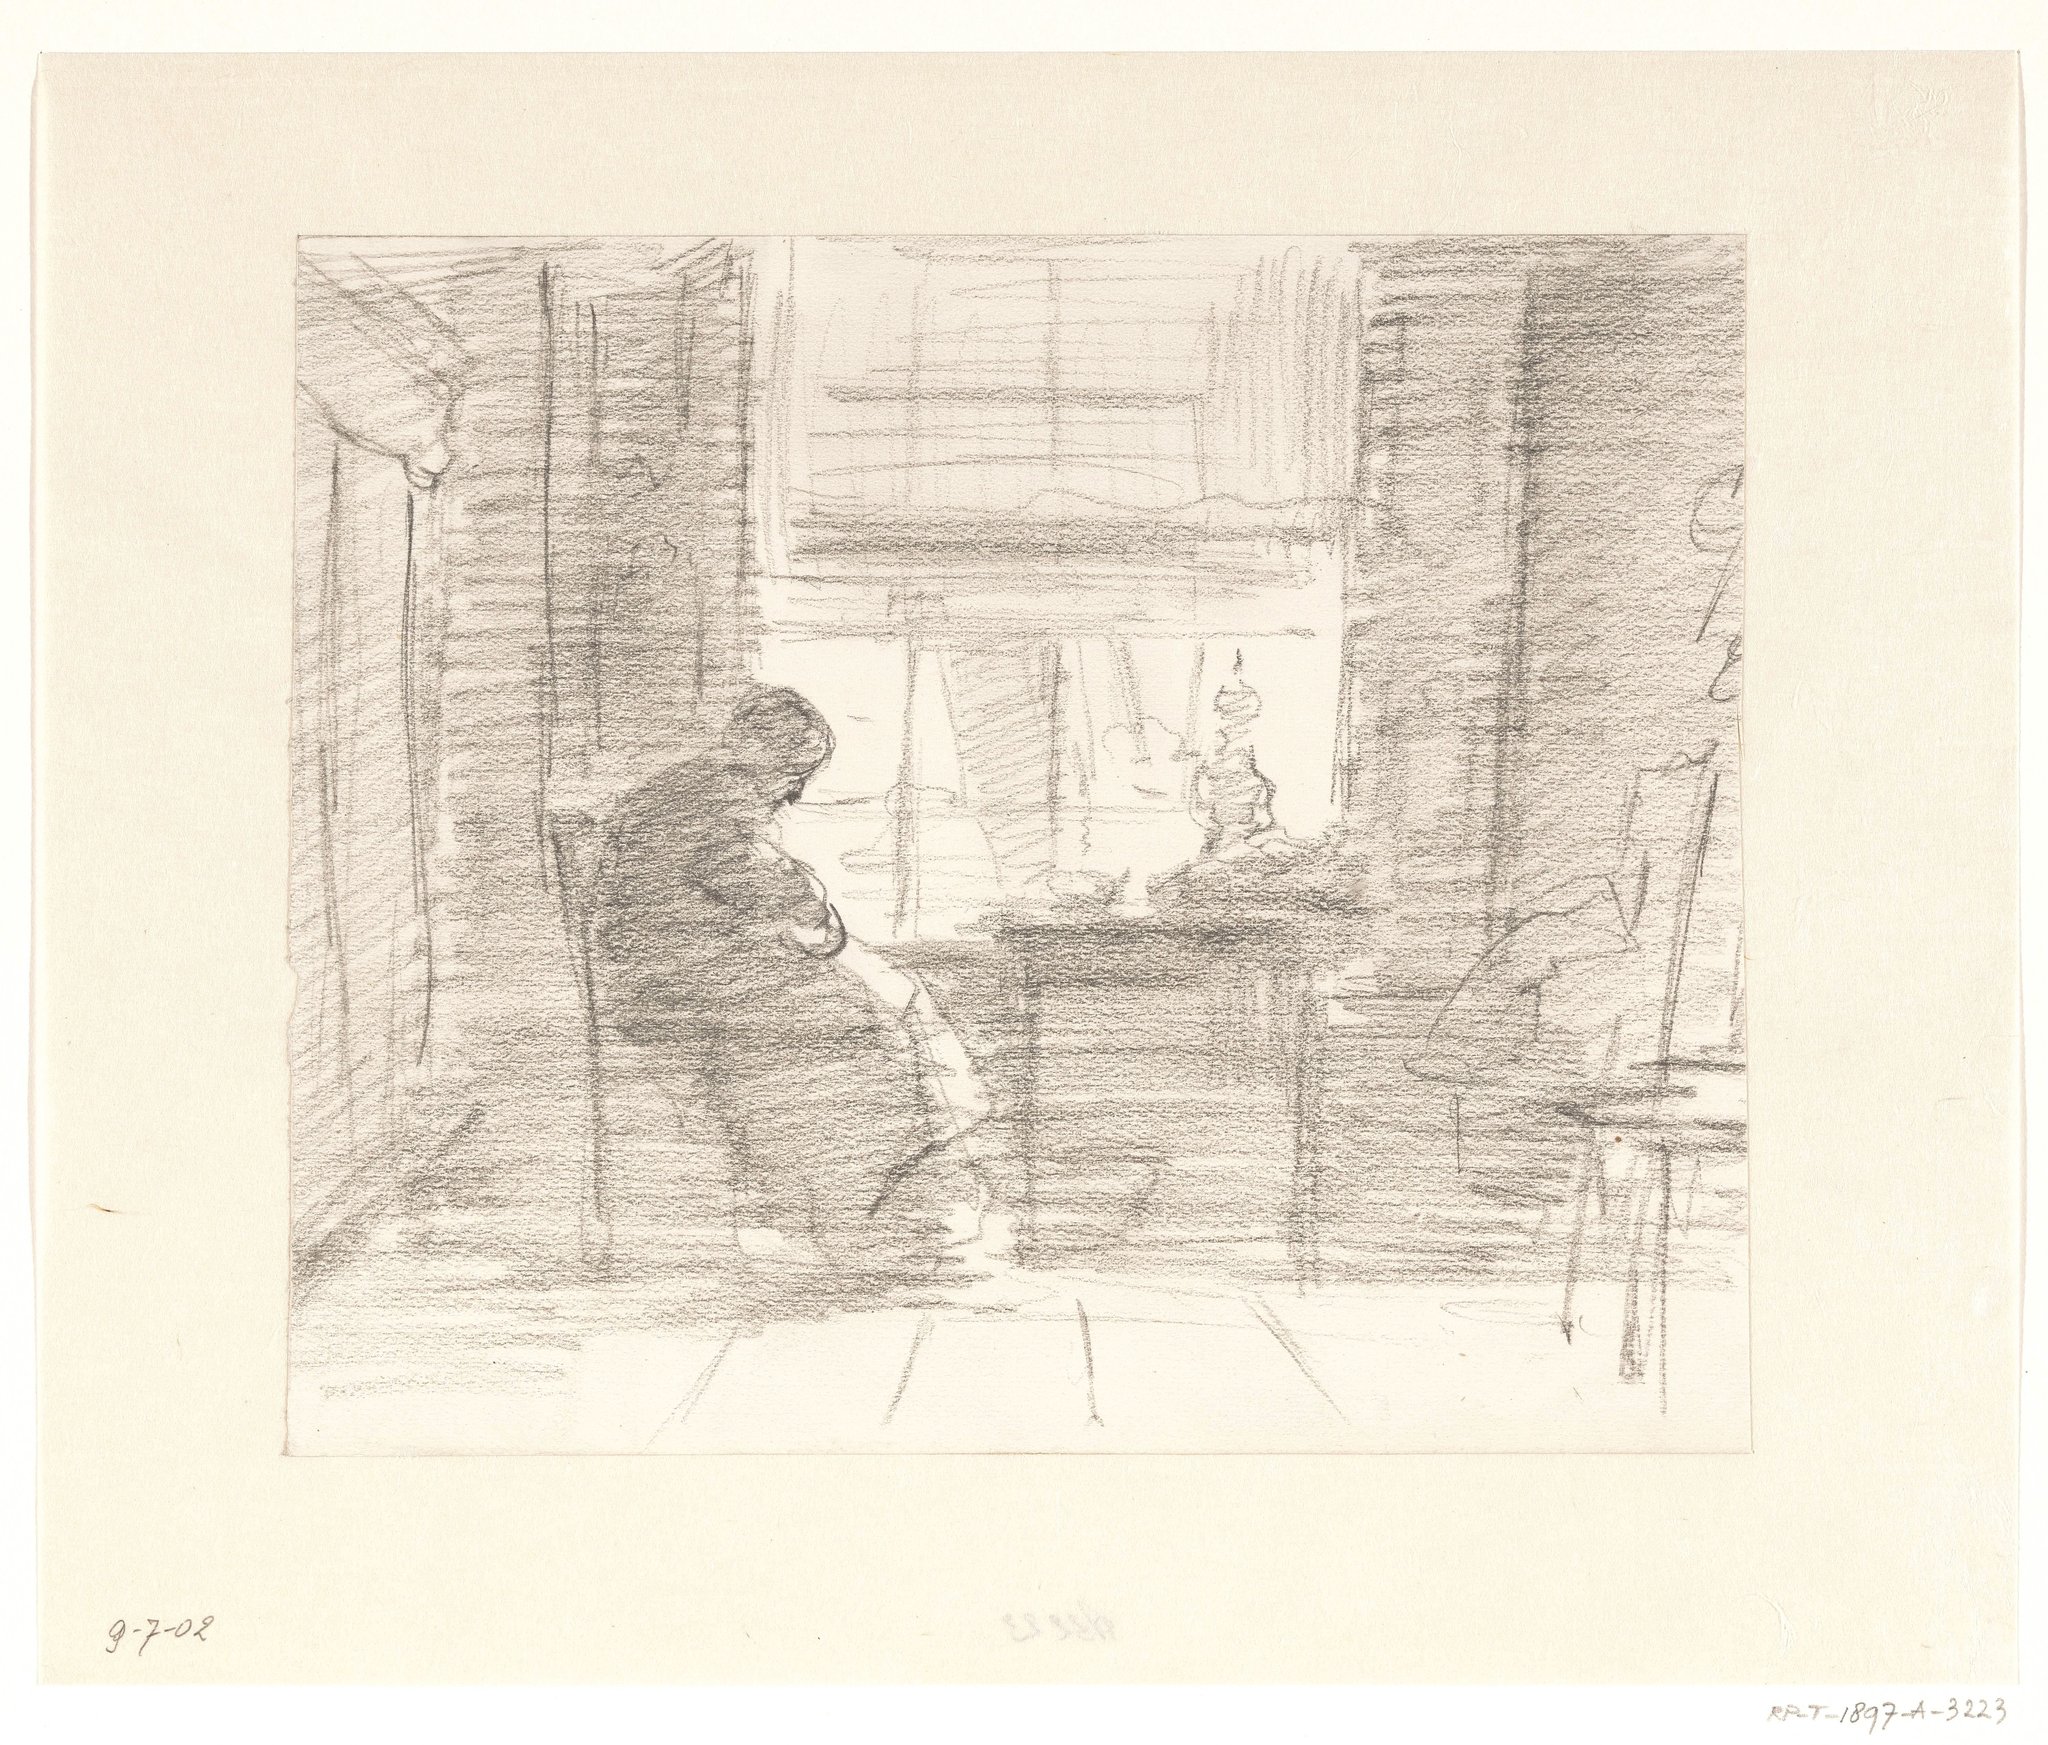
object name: drawing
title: Interieur met een oude vrouw bij een venster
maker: hendrik valkenburg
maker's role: draughtsman, painter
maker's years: 1826-1896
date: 1836-1896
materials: chalk, paper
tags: family group, especially parents with their child(ren), interior of the house